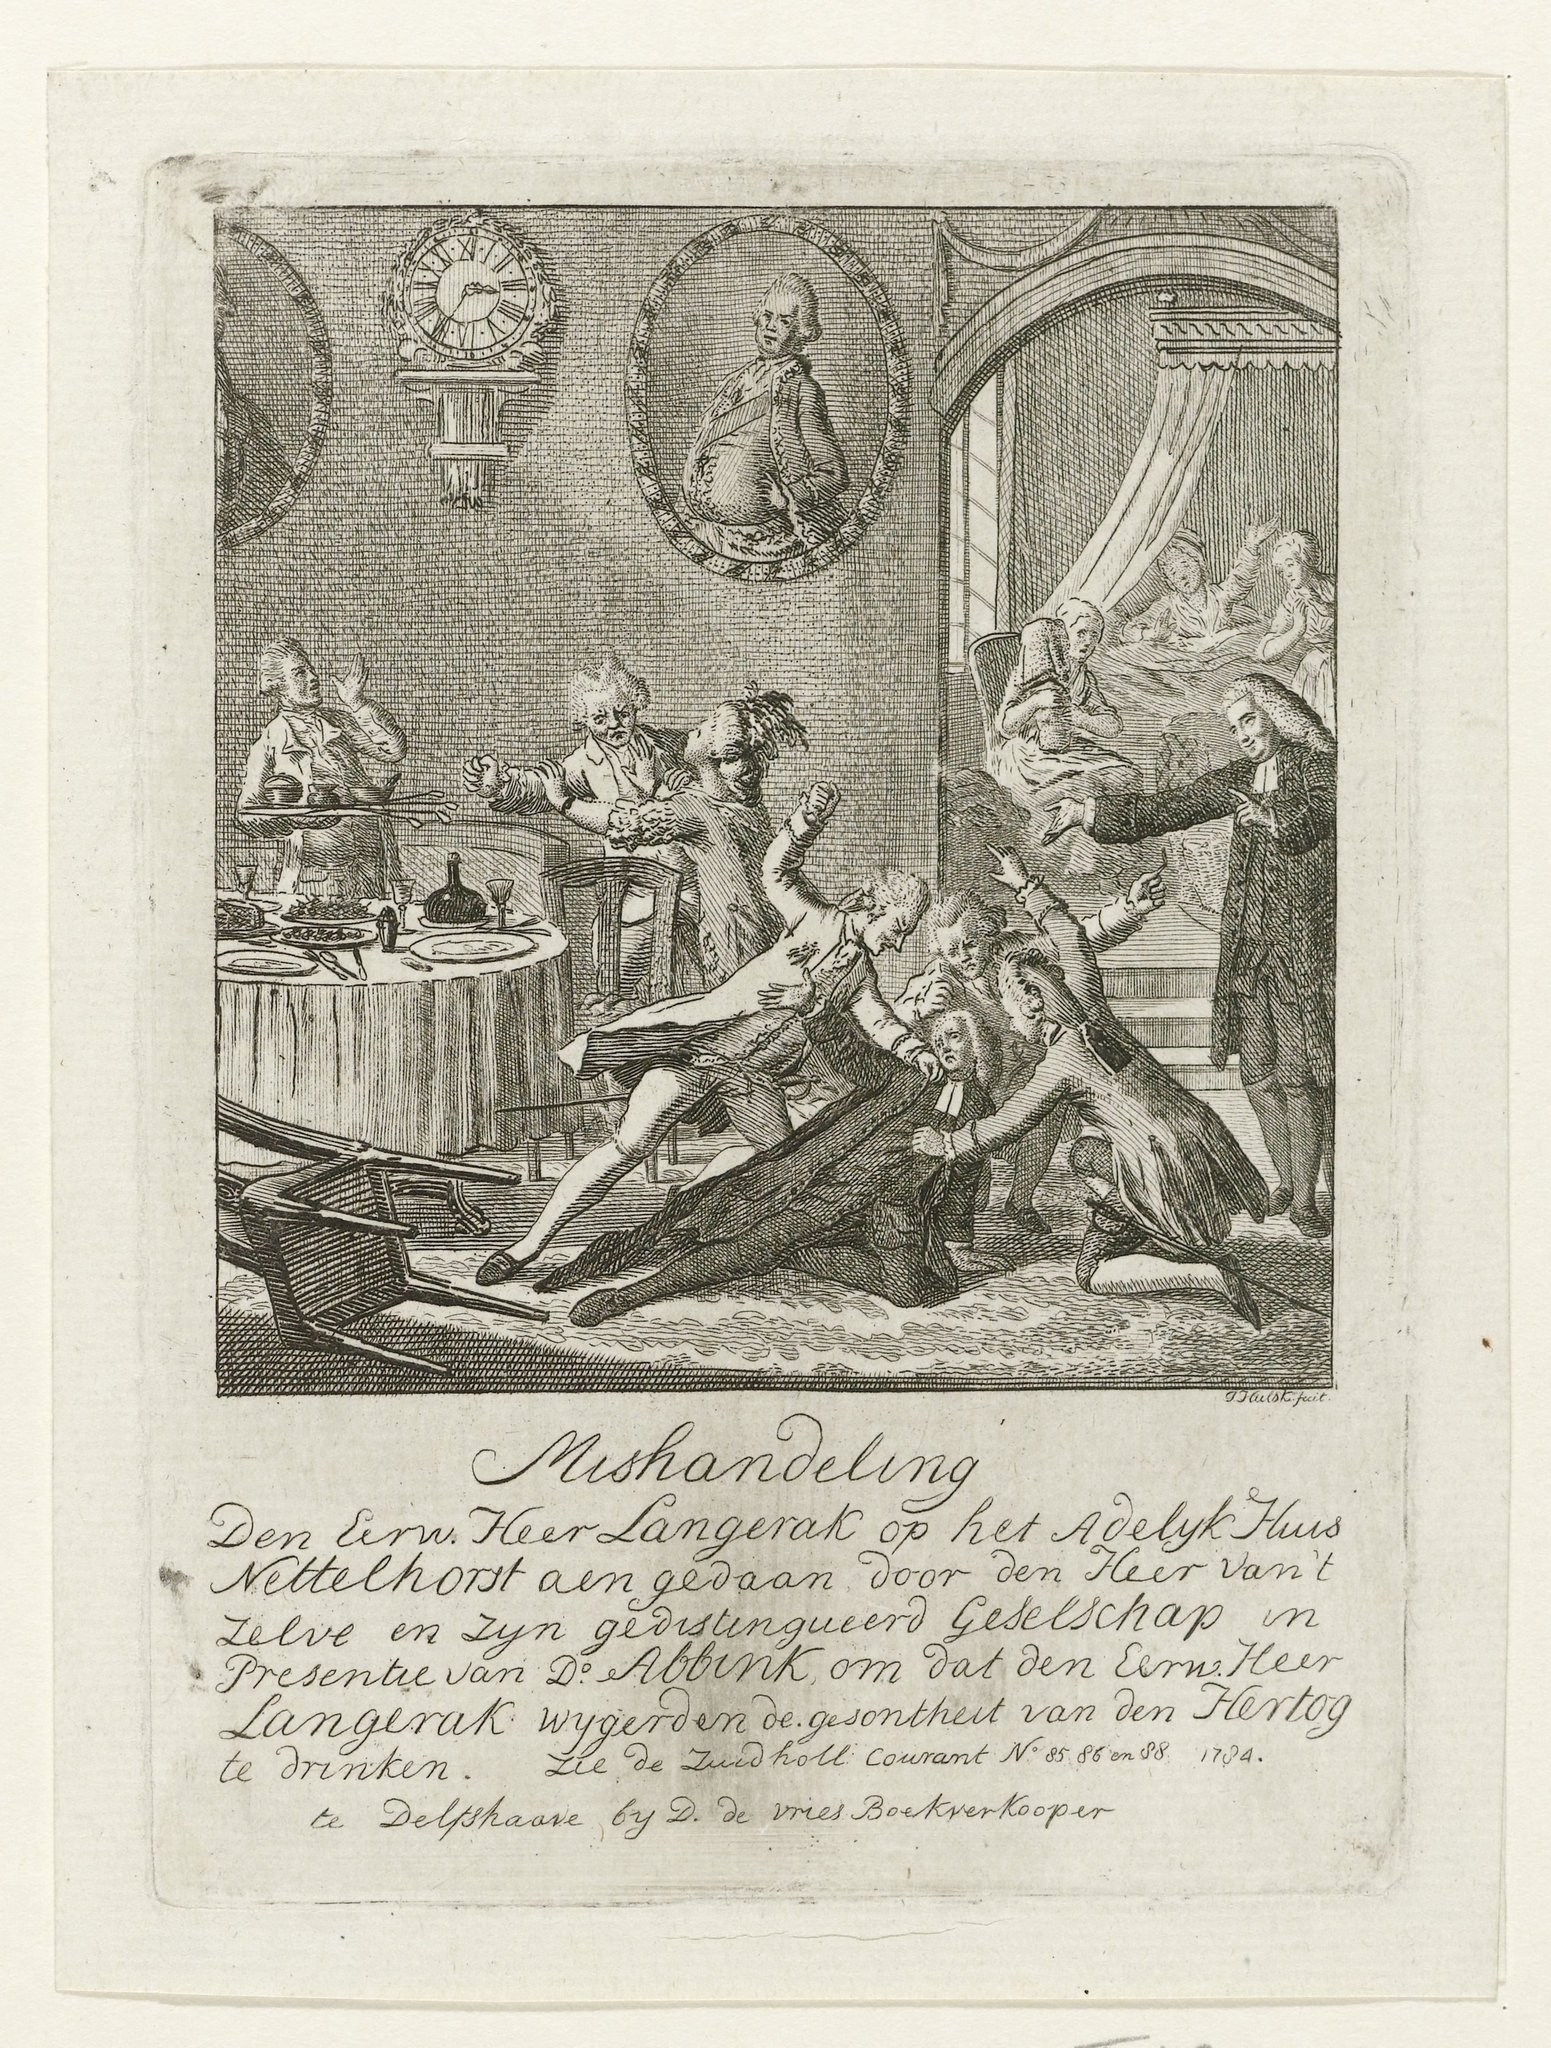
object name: print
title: Mishandeling Den Eerw. Heer Langerak op het Adelyk Huis Nettelhorst aengedaan door den Heer van 't Zelve (...)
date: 1784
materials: paper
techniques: engraving, etching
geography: northern netherlands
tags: ludwig ernst von braunschweig-wolfenbüttel, fist-fight, patriots (1780-1795)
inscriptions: collector's mark: Lugt 2228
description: Mishandeling van de predikant Langerak uit Laren op het Huis Nettelhorst bij Lochem door baron van Heeckeren, burgemeester De Wolff van Lochem en de heer Sölner omdat de predikant weigerde te drinken op de gezondheid van de hertog van Brunswijk, juli 1784. Rechts kijkt de Lochemse predikant Abbink goedkeurend toe. Aaan de muur een schilderij met portret van de hertog van Brunswijk. Bij de prent behoort een tekstblad met uitleg.